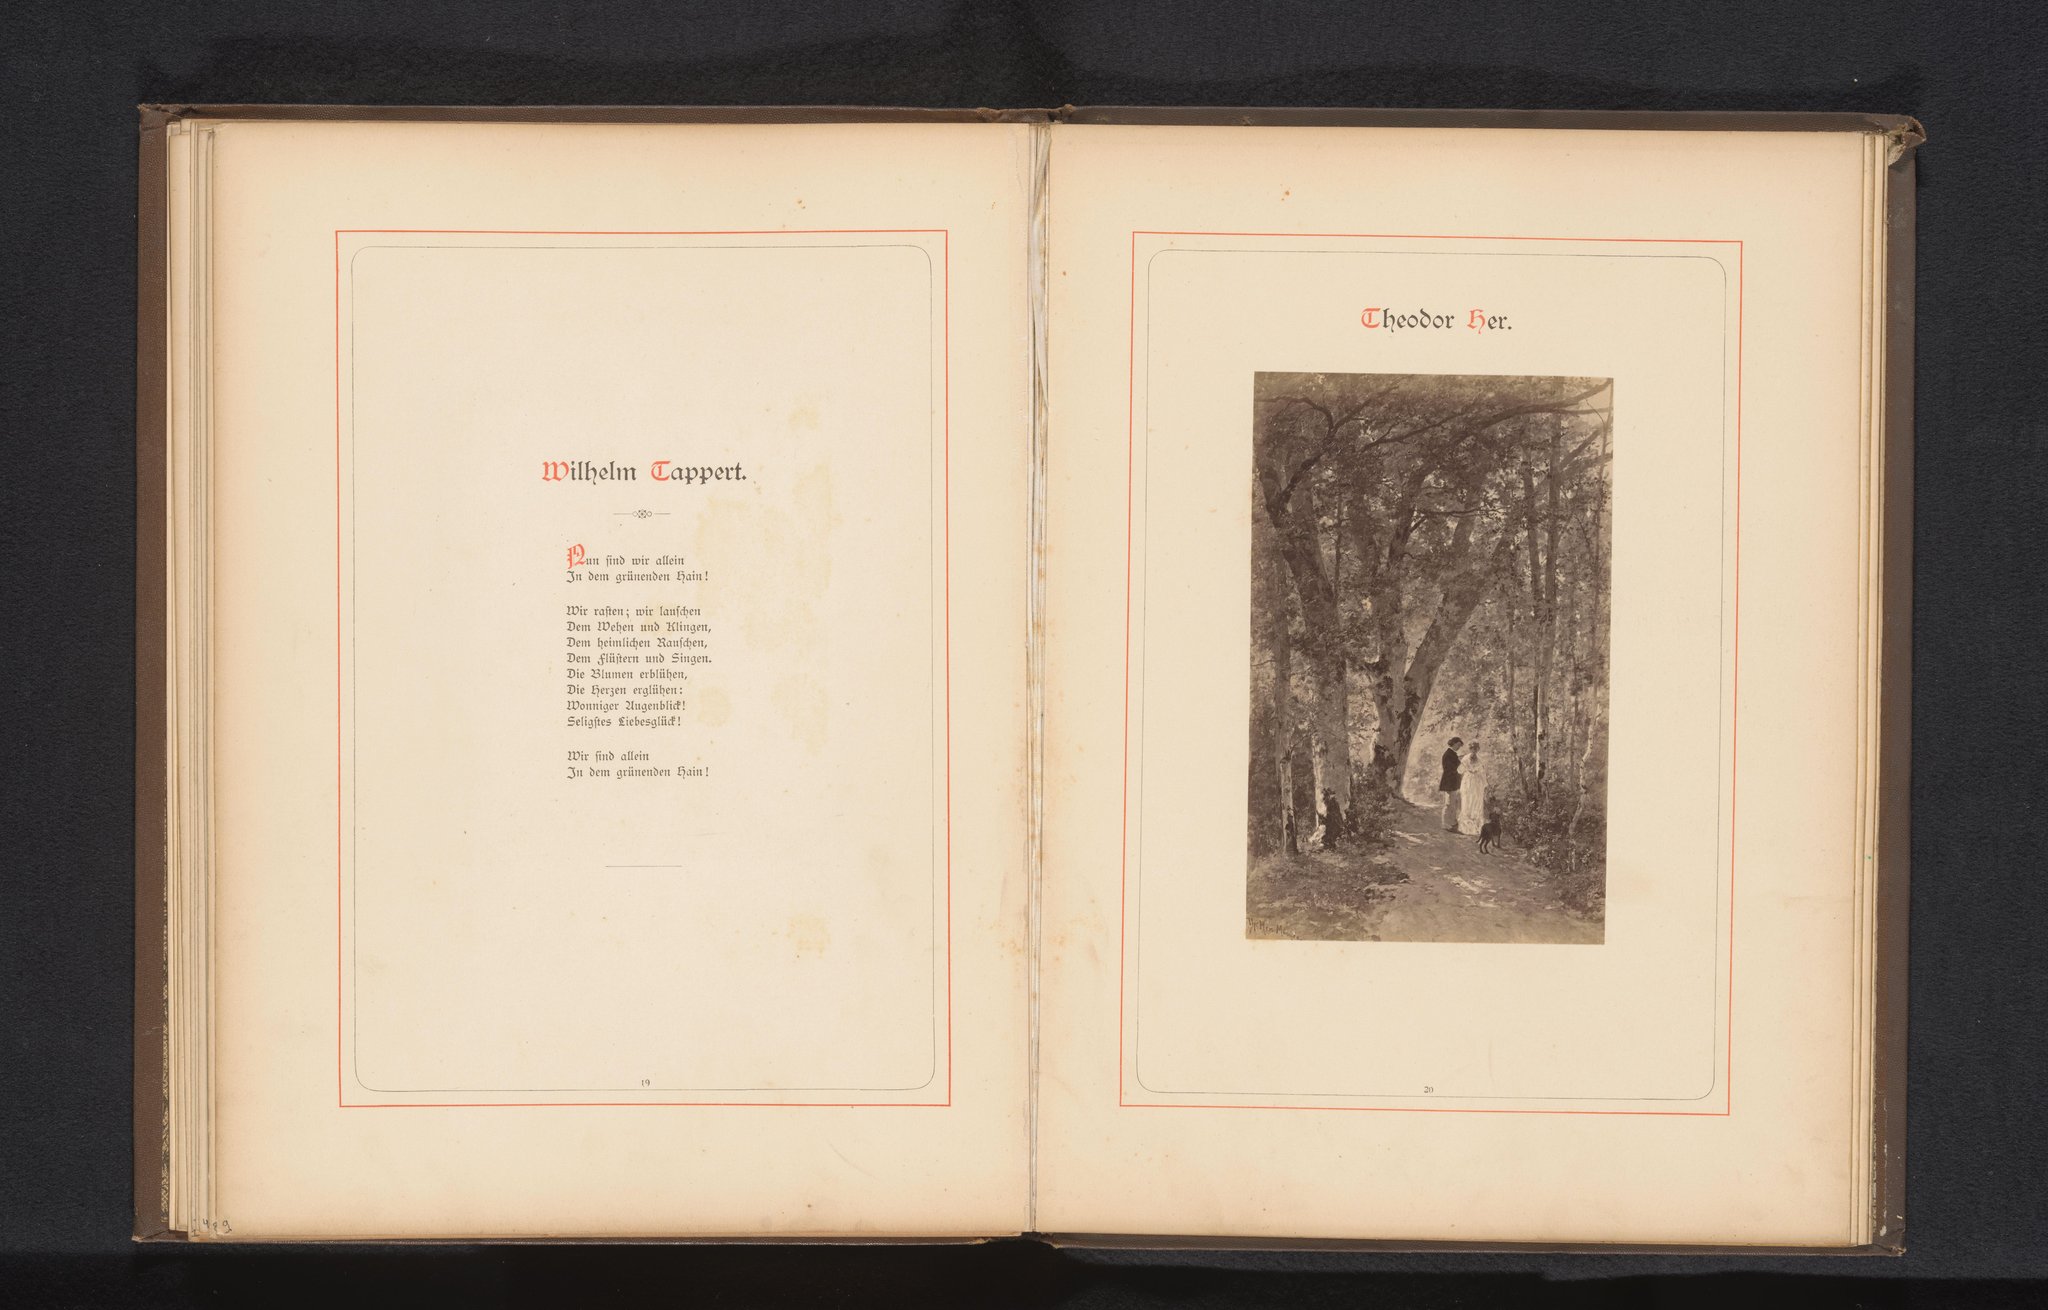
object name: reproduction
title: Fotoreproductie van een schilderij door Theodor Her, voorstellende een man en een vrouw met een hond op een bospad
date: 1875-1885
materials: photographic support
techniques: albumen print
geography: munich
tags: forest path or lane, picture, painting, dog